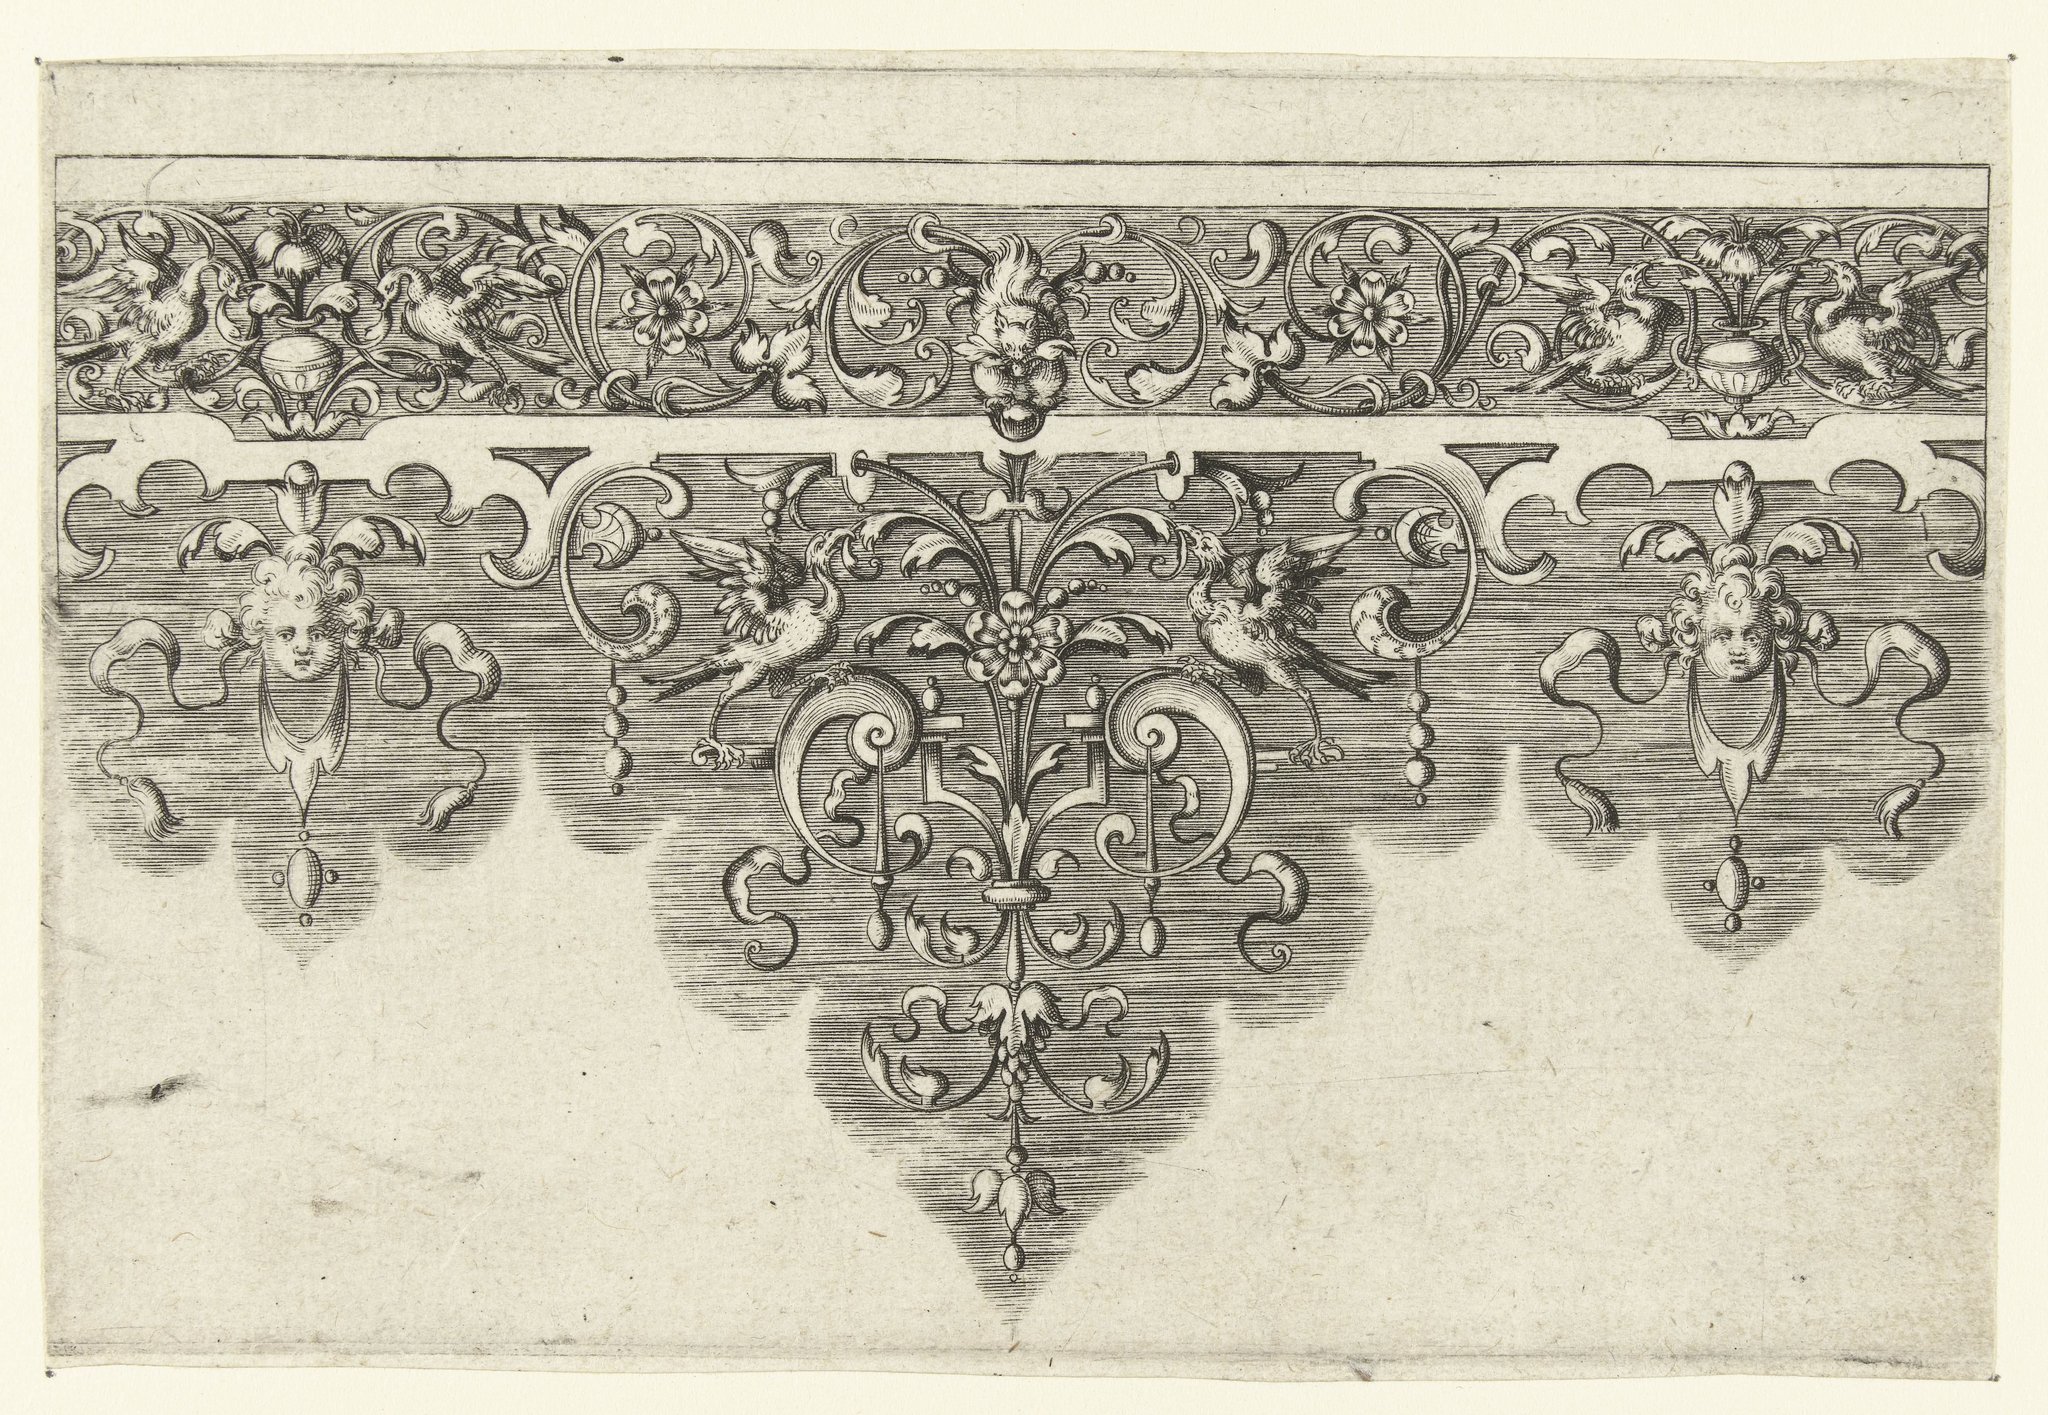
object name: ornament print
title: Varii generis opera aurifabris necessari (...)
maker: paul birckenhultz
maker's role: print maker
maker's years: 1561-1639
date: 1571-1639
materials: paper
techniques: engraving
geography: germany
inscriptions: collector's mark: Lugt 240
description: Fries bovenaan, gedecoreerd met bladranken en zowel links als rechts een vaas tussen twee vogels. Blad uit een serie bestaande uit een titelblad en 9 bladen met decoratie voor randen van bekers. Op de bladen zijn bladranken met grotesken en mascarons te zien tegen een gearceerde achtergrond op een verder ongearceerd blad.